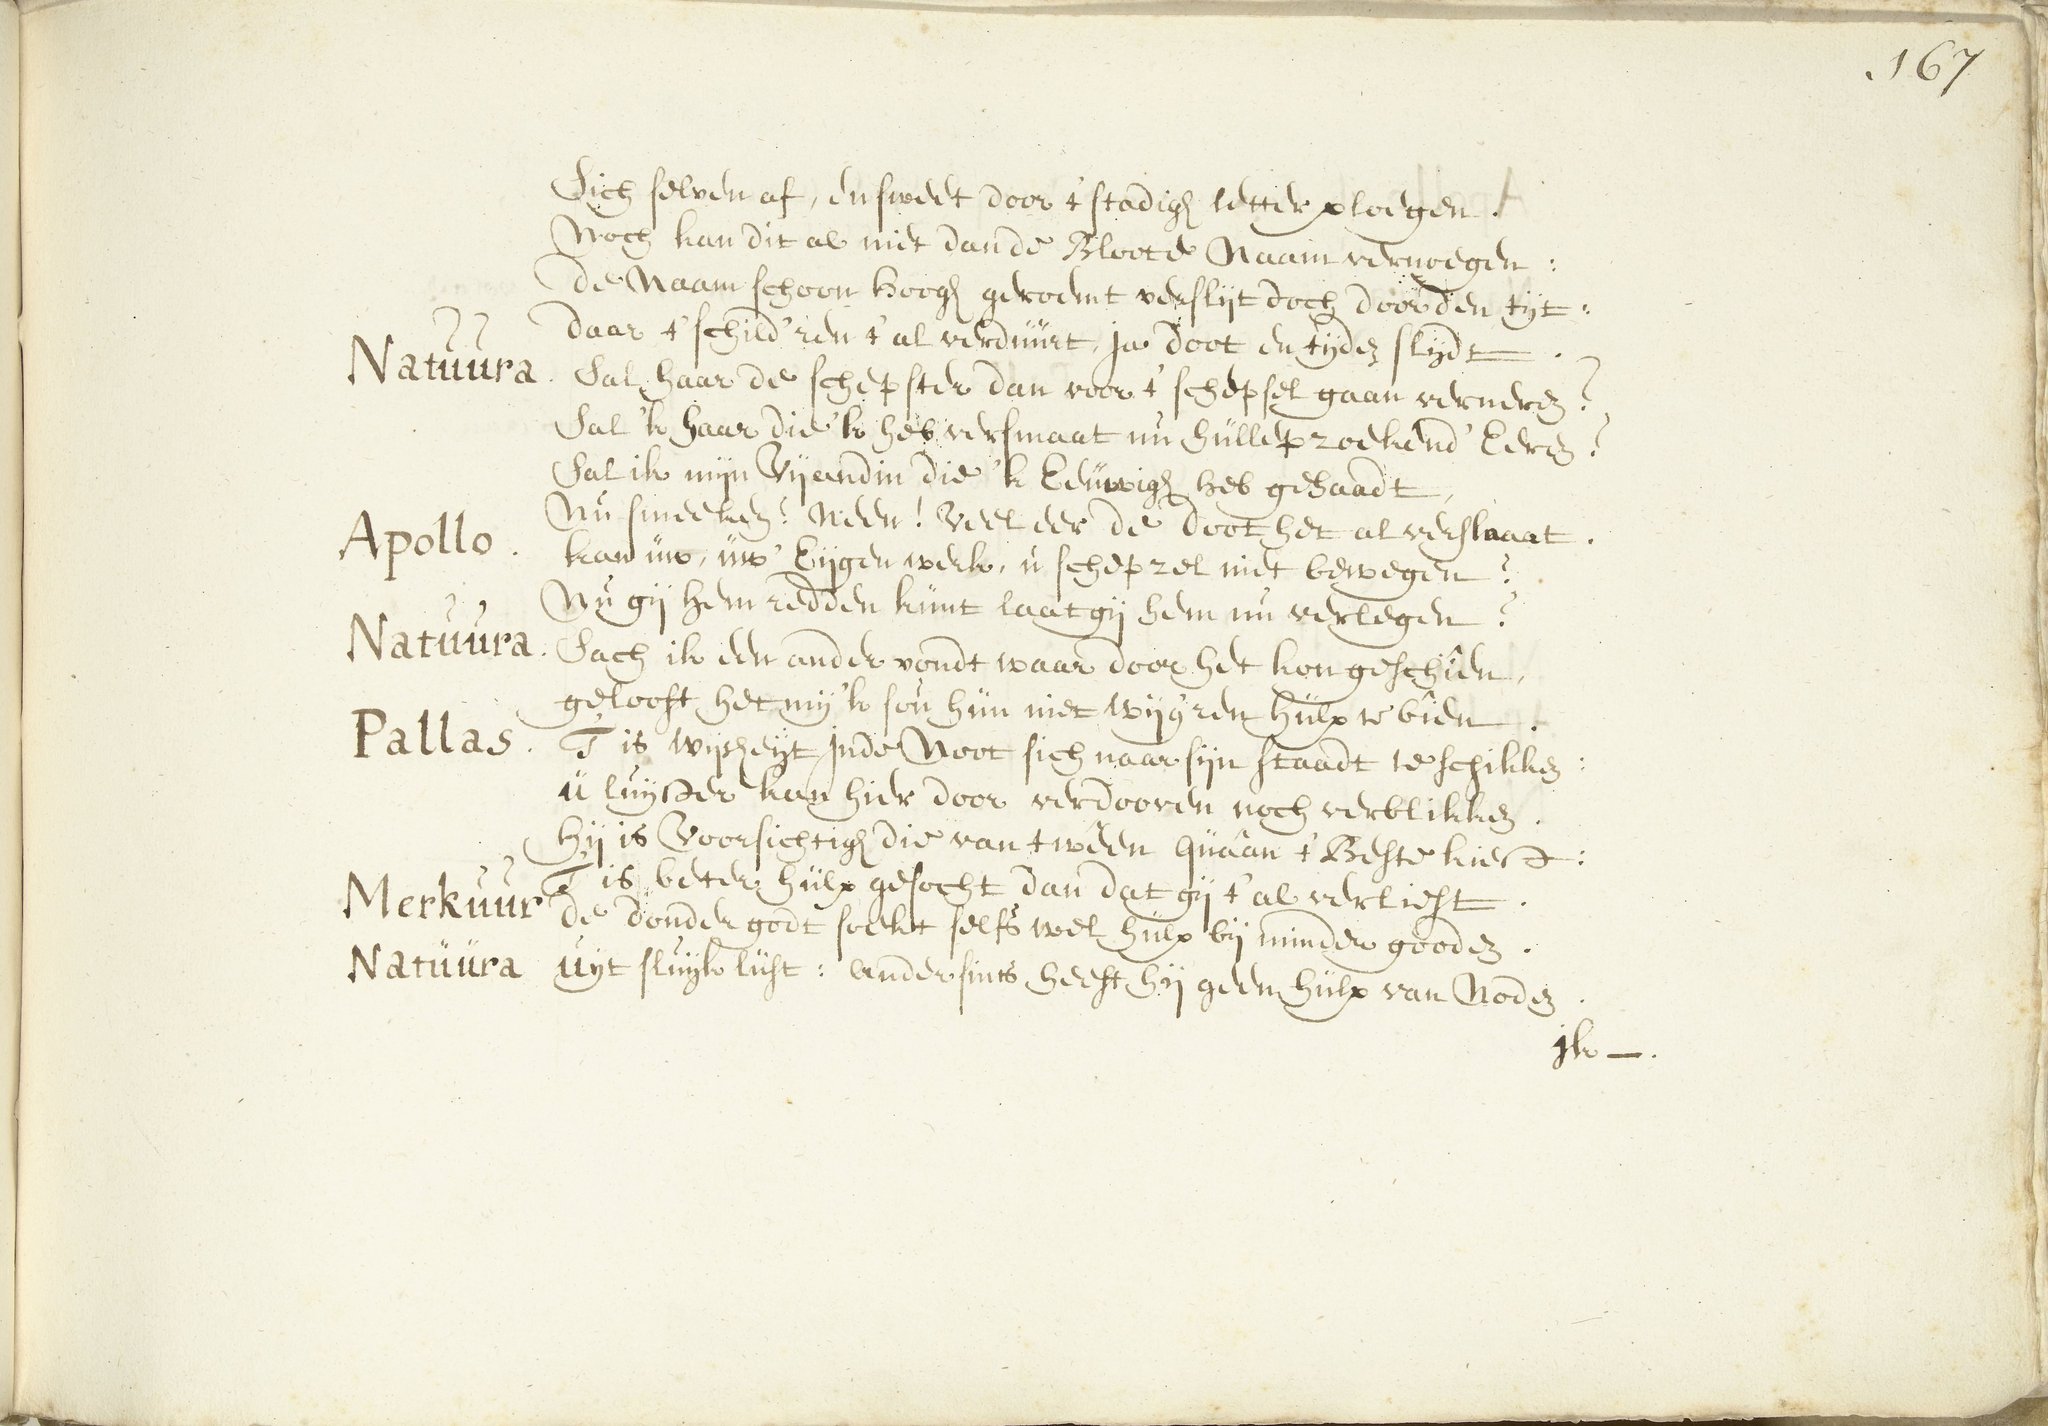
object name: text sheet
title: Strijd tussen Dood en Natuur of Zege der Schilderkunst (deel 9)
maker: henrik jordis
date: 1660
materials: ink, paper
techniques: writing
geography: zwolle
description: Vervolg van het toneelstuk Gooden Pleijdt ofte Triomphe der Schilderconst over de Doodt. In het toneelstuk beraden Apollo, Mercurius, Pallas Athene en Natuur zich over de manier waarop de Dood overwonnen kan worden en roepen zij de hulp van Schilderkunst in.